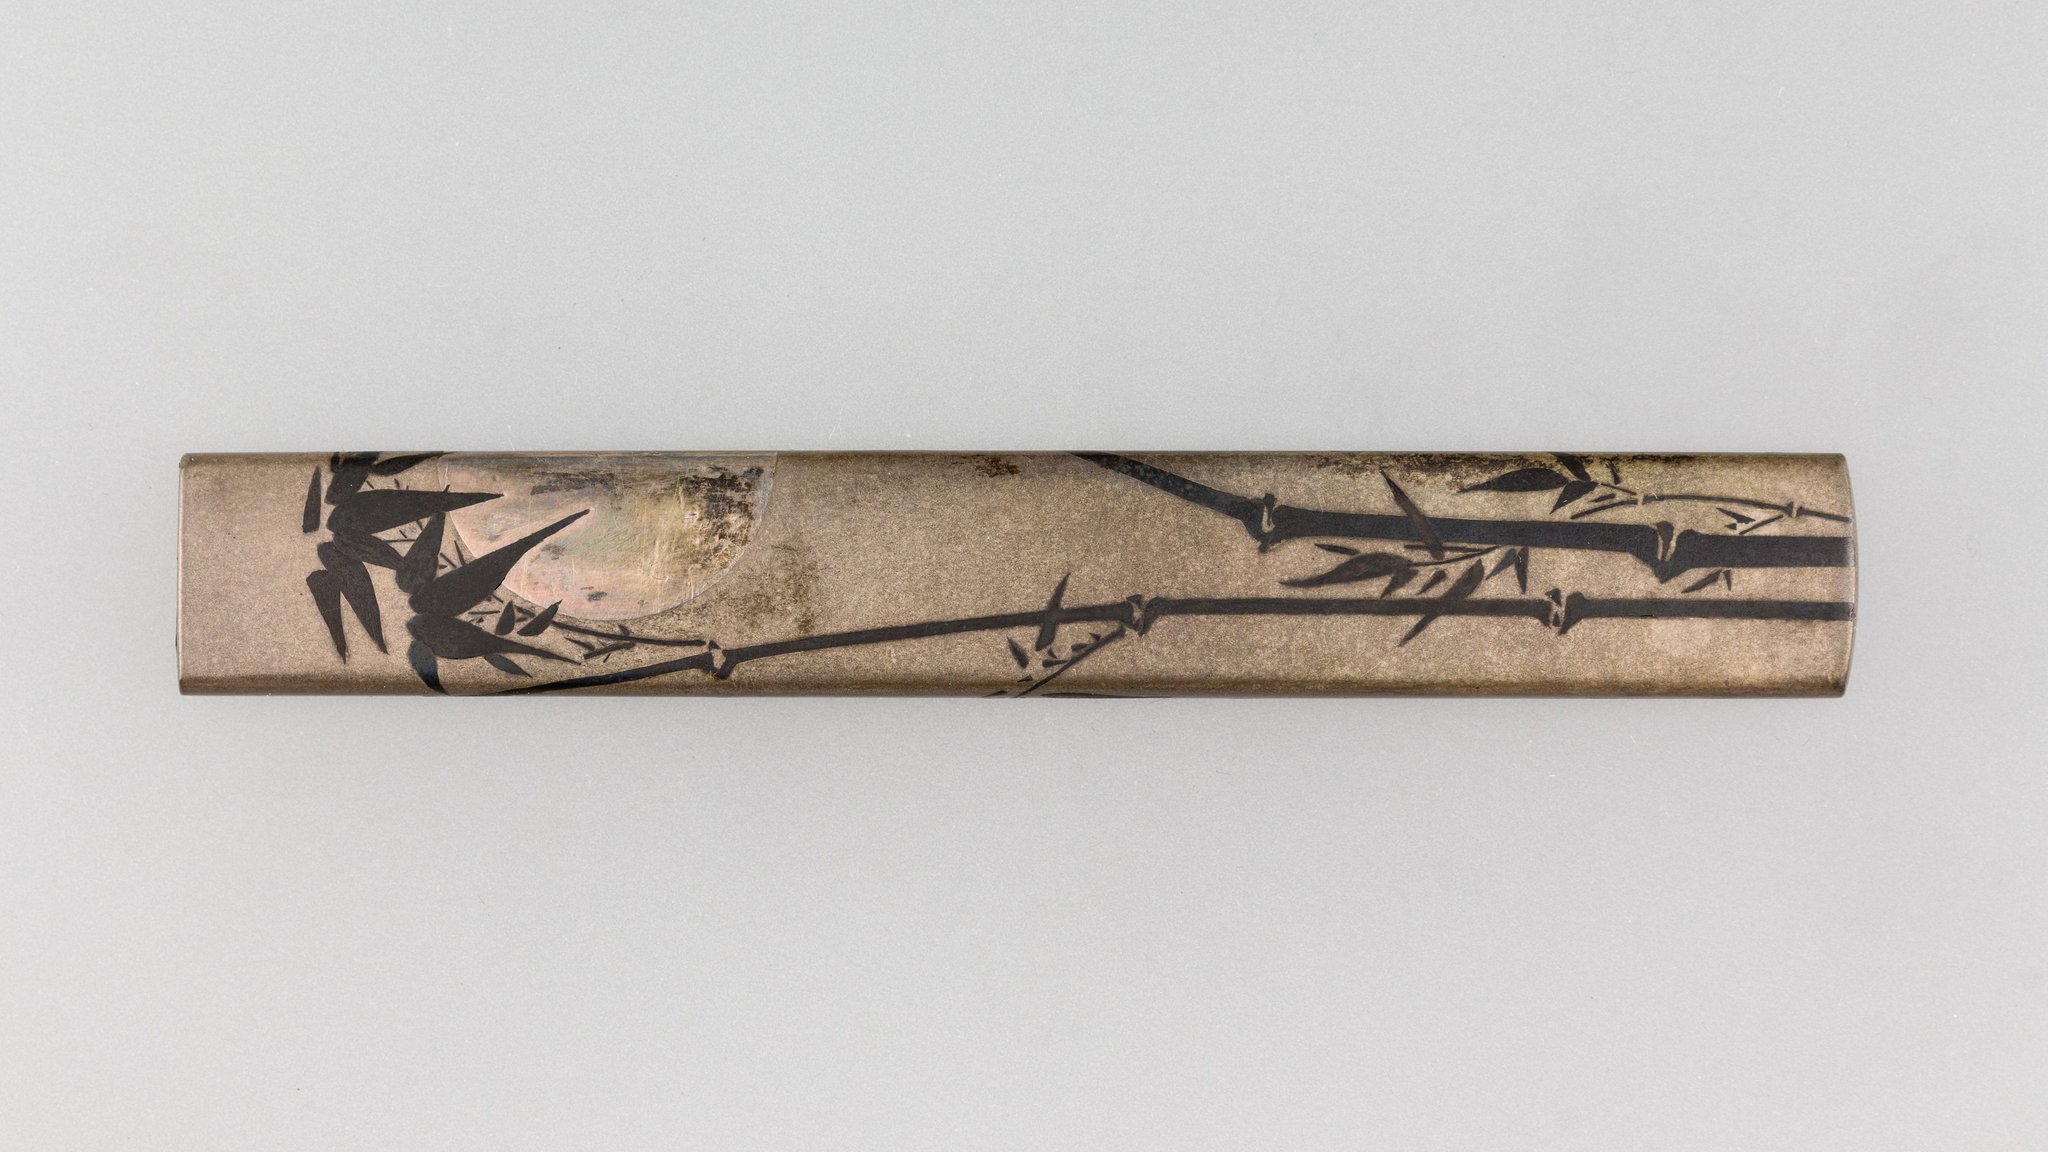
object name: knife handle kozuka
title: Knife Handle (Kozuka)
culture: japanese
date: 1793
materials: gold alloy, silver alloy, silver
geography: japan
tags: bamboo